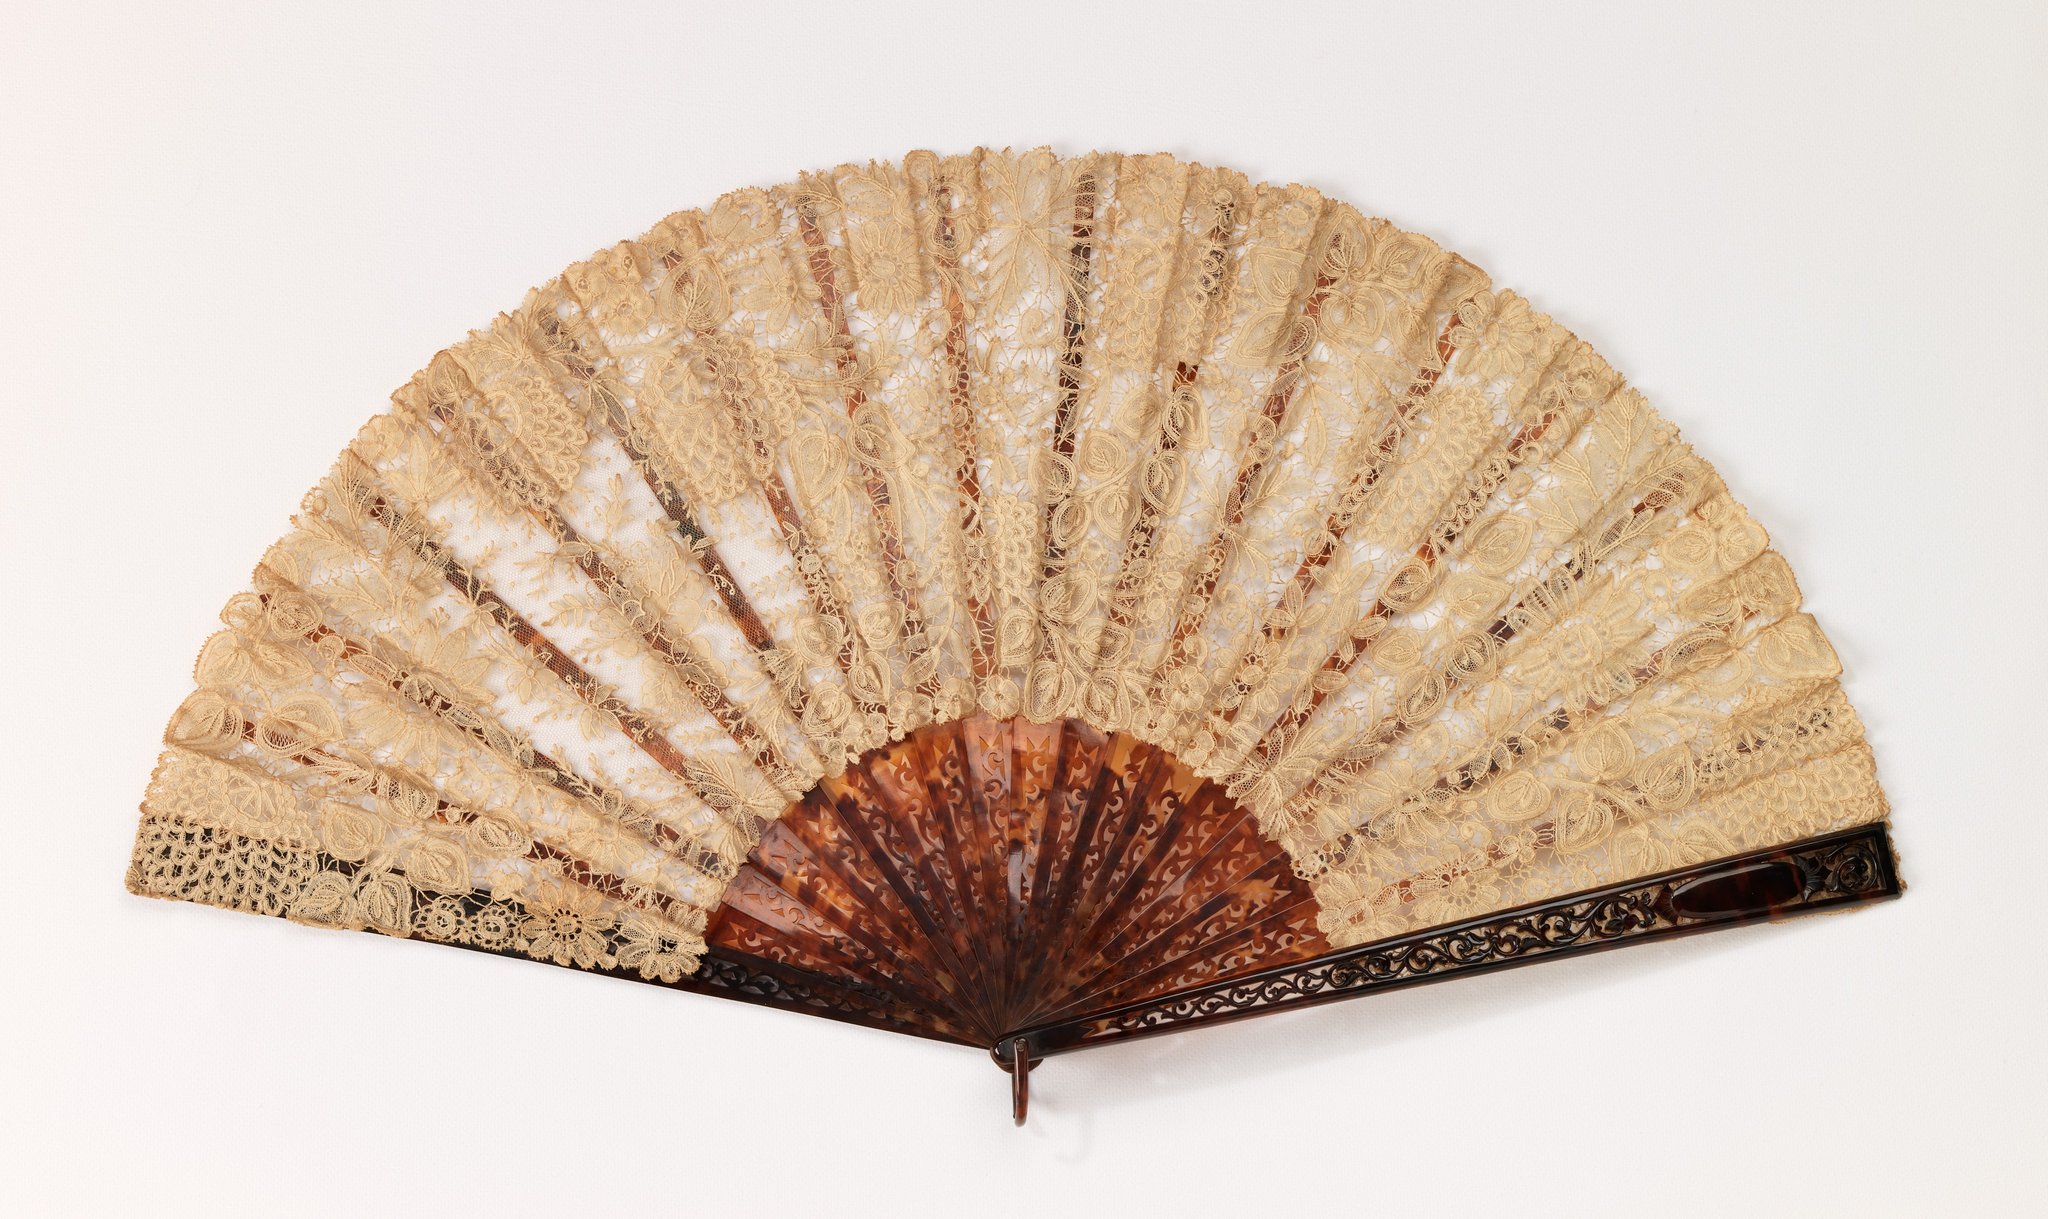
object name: fan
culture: european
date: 1885-1895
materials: linen, shell